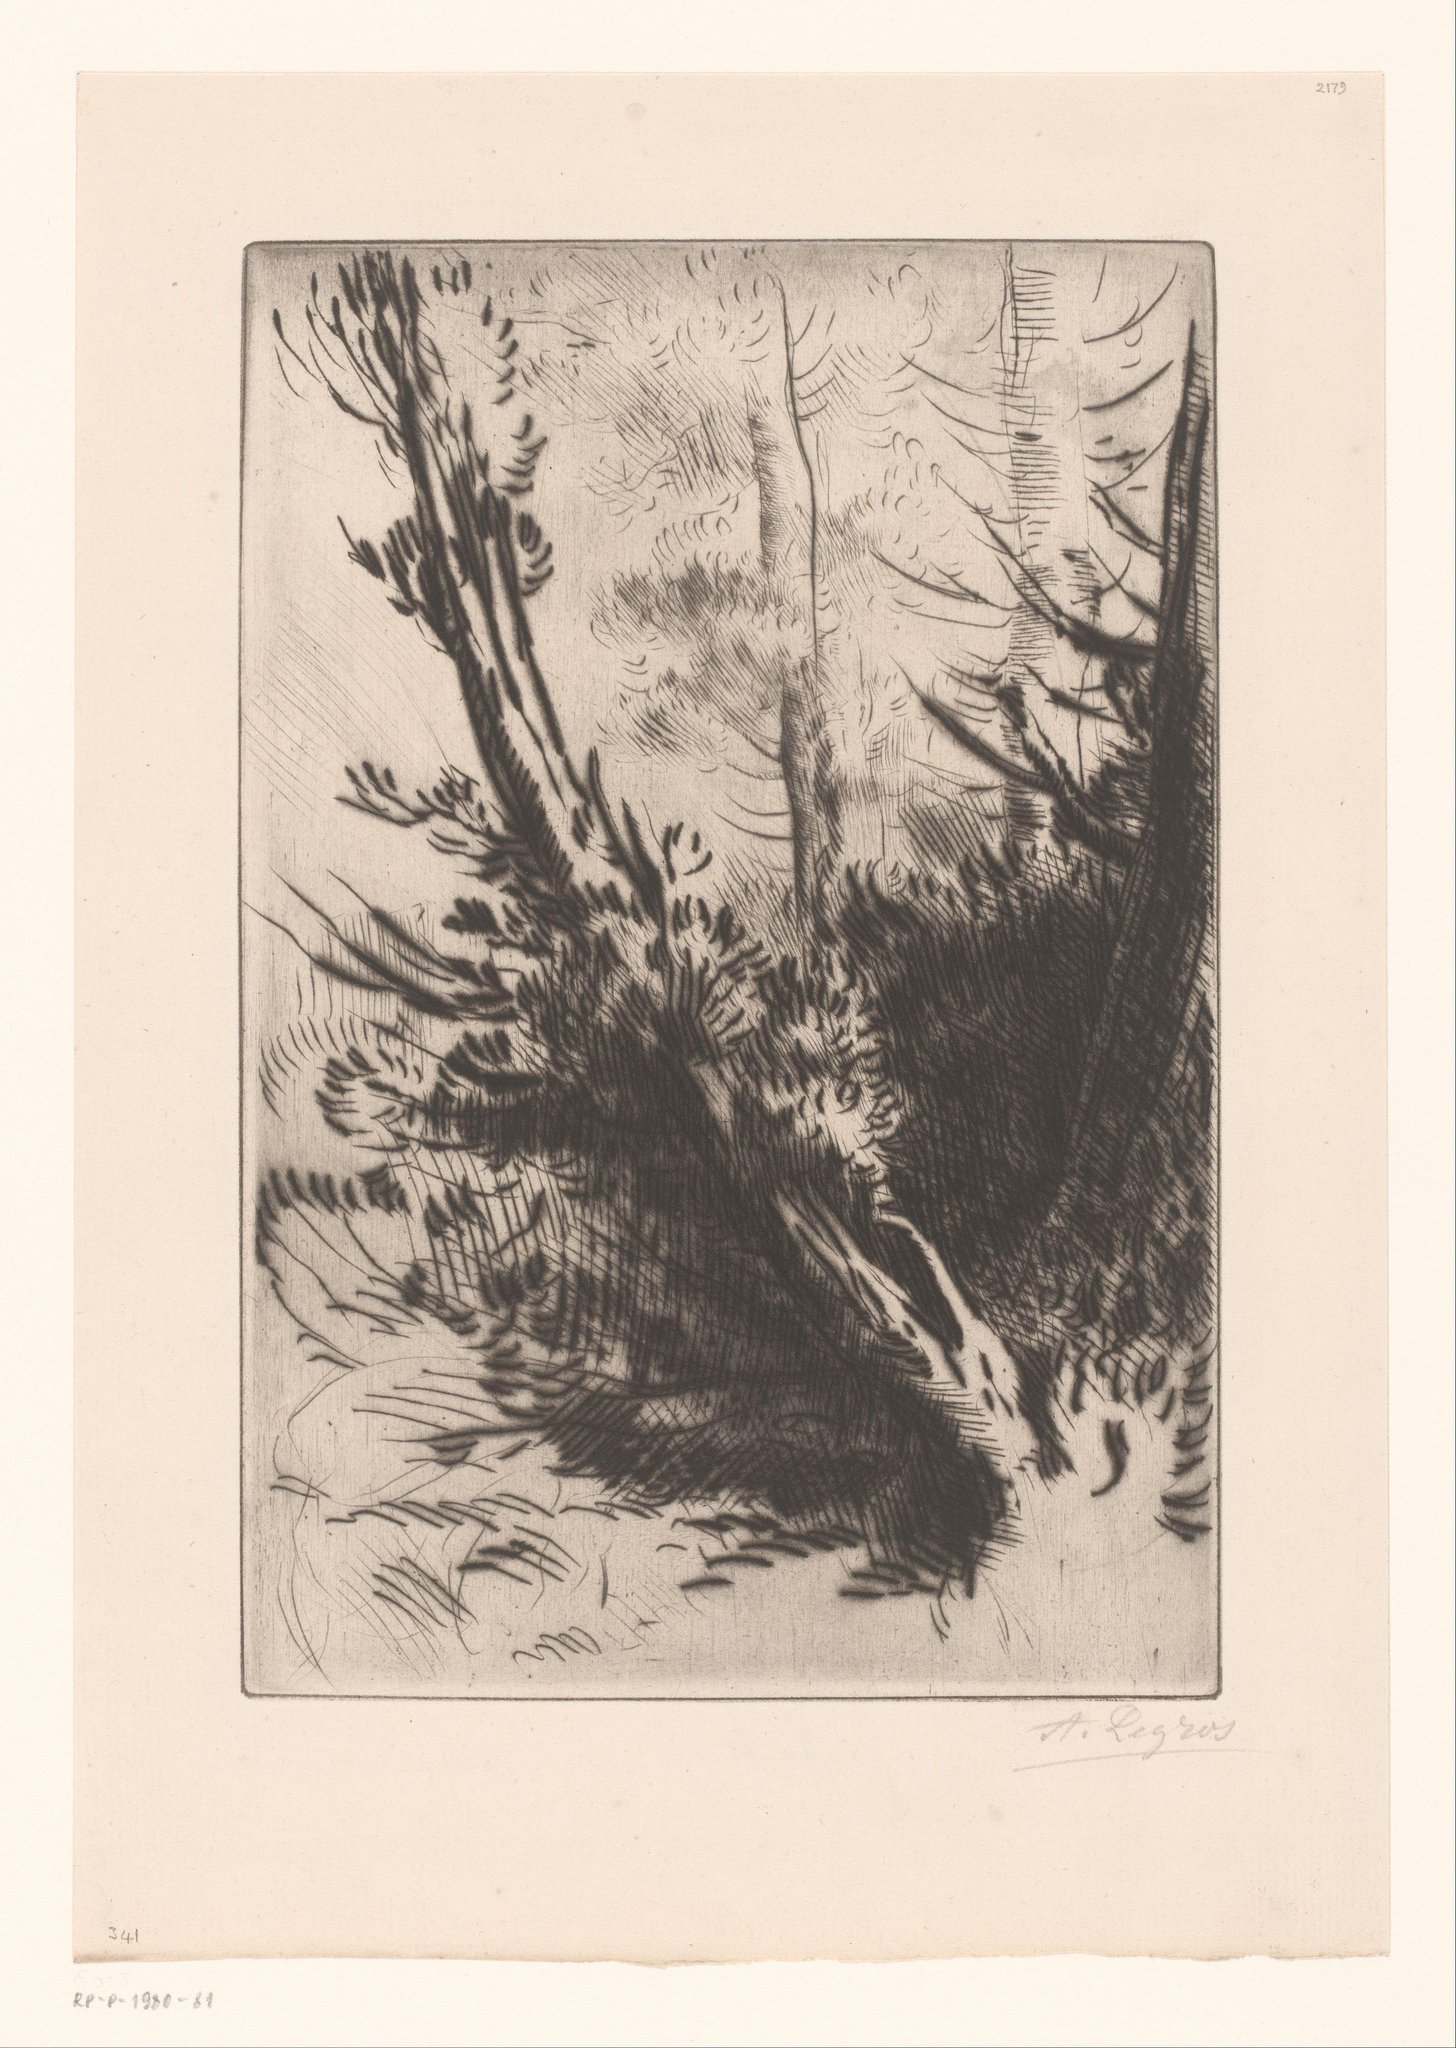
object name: print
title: Bomen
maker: alphonse legros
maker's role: print maker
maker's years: 1837-1911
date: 1847-1911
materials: paper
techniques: drypoint, intaglio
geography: france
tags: trees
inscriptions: collector's mark: Lugt 2228, collector's mark: Lugt 2760